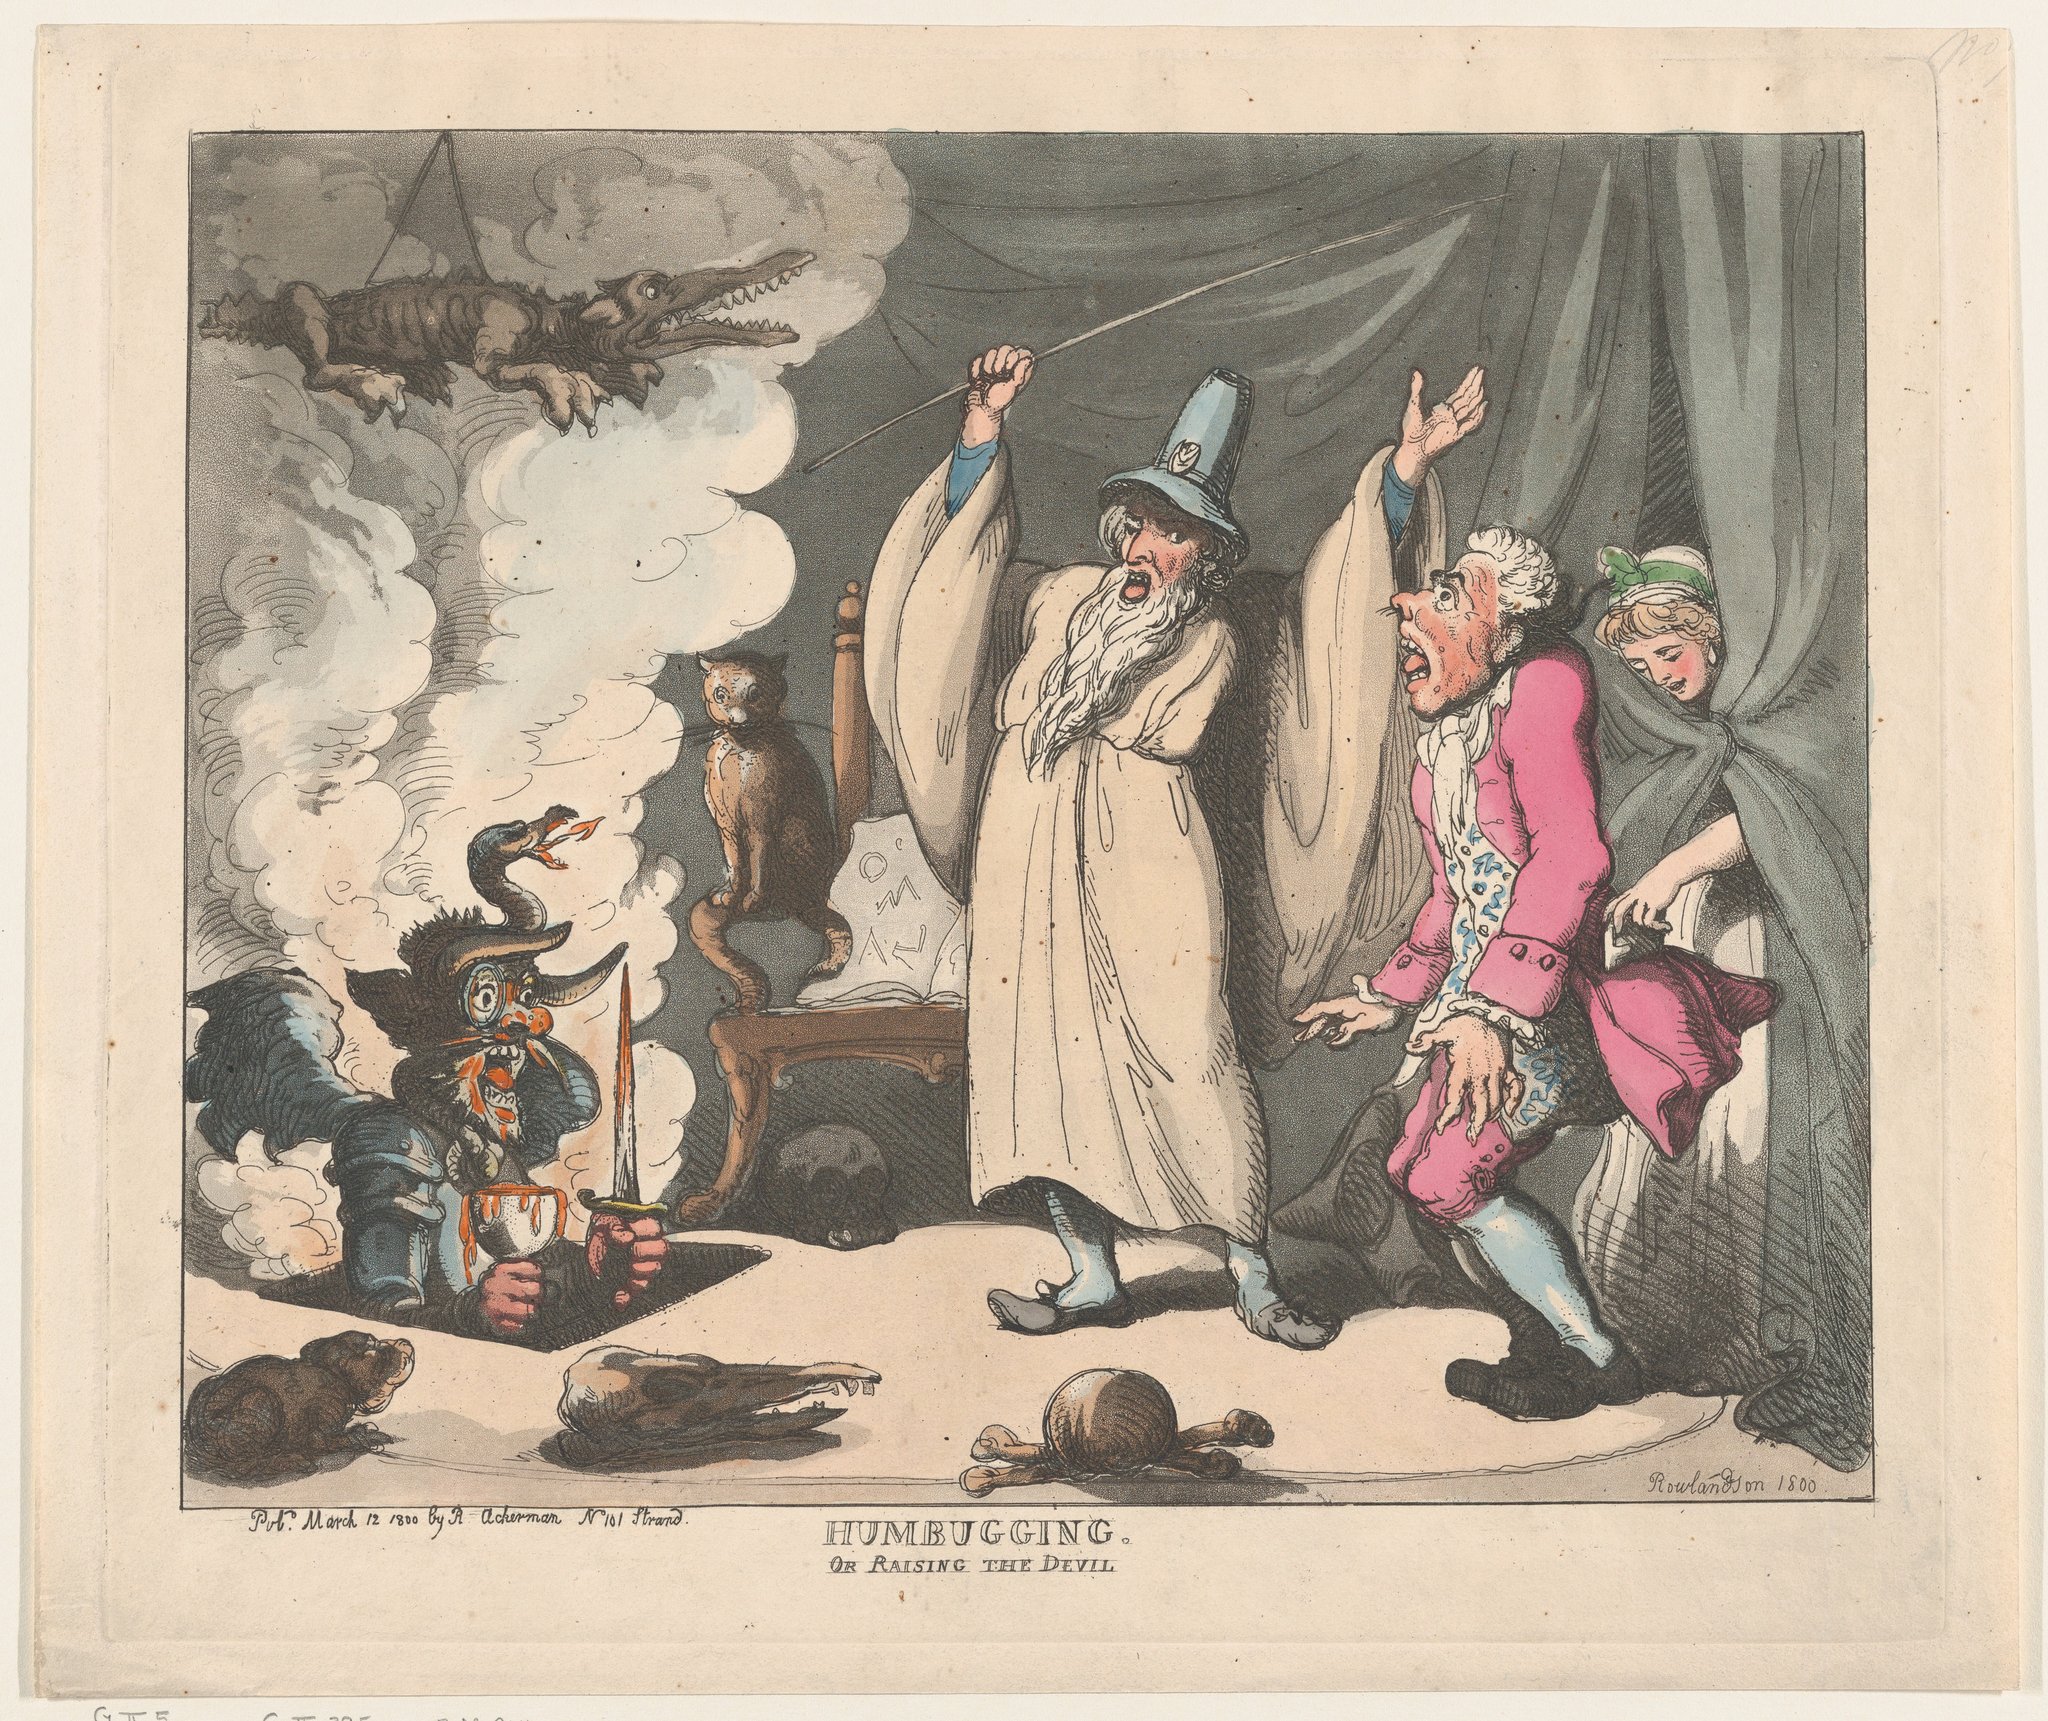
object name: print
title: Humbugging, or Raising the Devil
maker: thomas rowlandson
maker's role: artist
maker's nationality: british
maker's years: 1757-1827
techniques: aquatint, etching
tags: animals,satire,men,crocodiles,devil